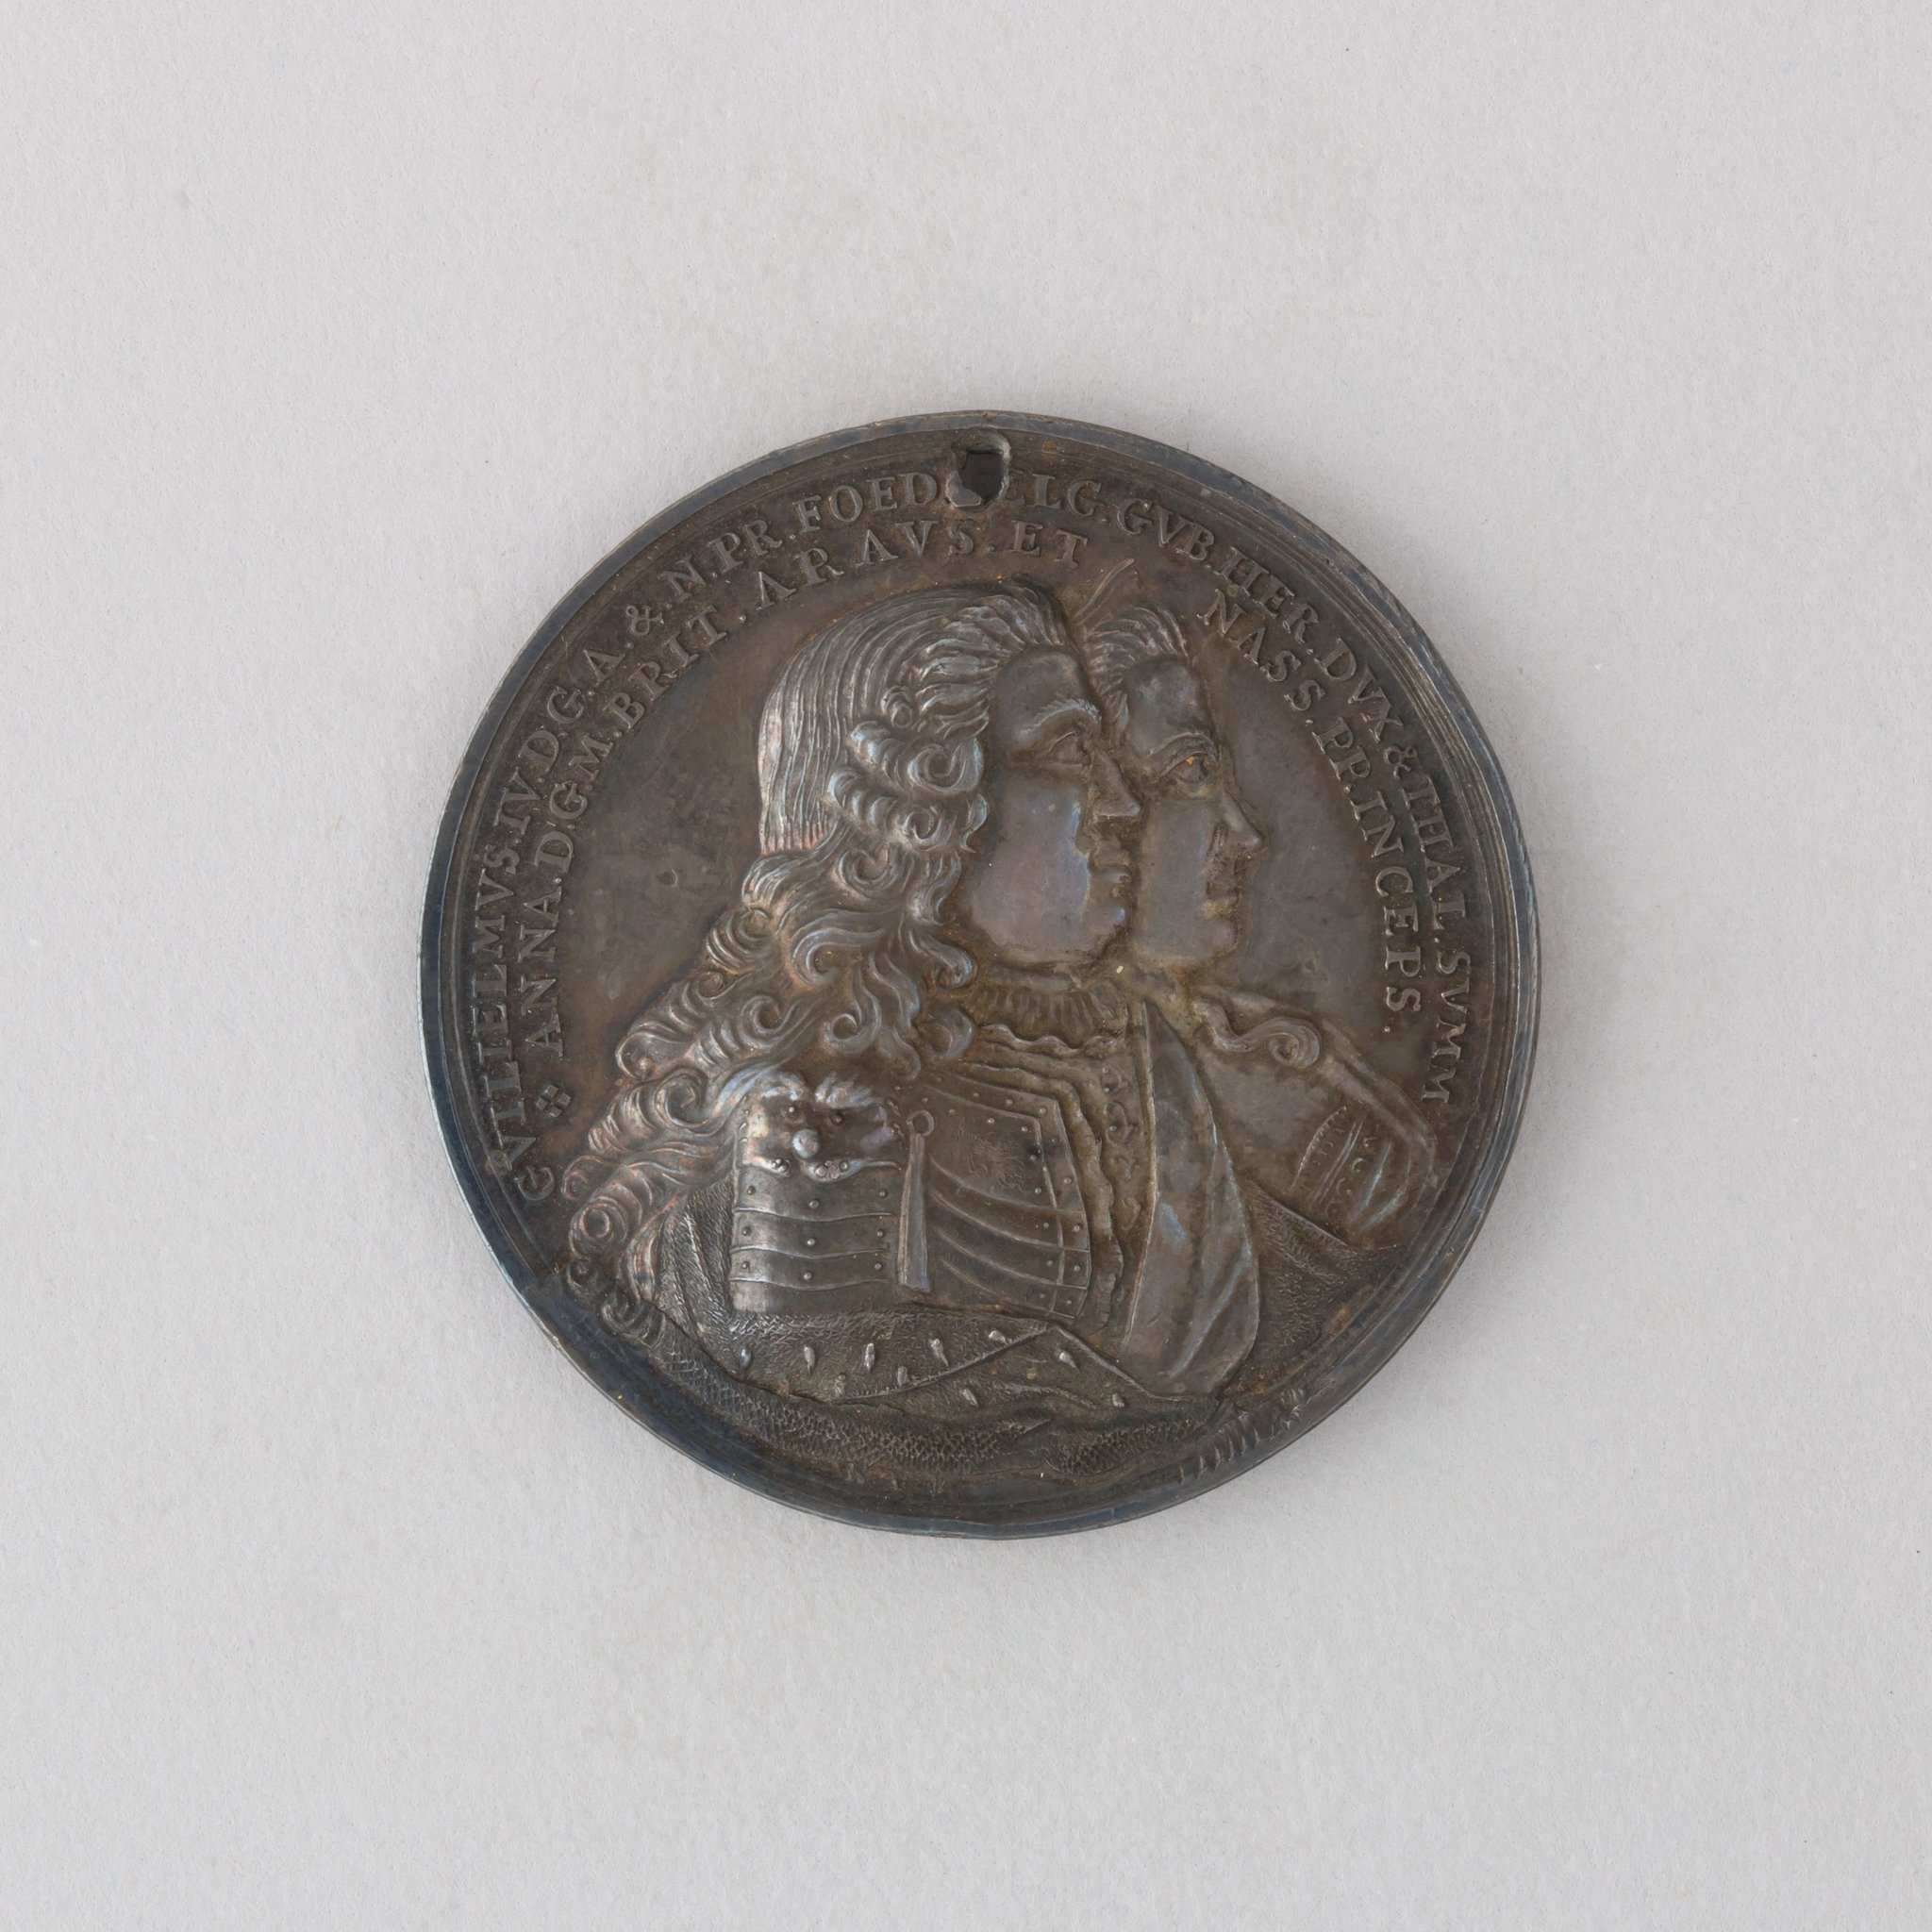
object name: medal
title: Medal Showing the Birth of Prince William of Orange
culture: dutch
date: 1748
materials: bronze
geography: netherlands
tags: men,profiles